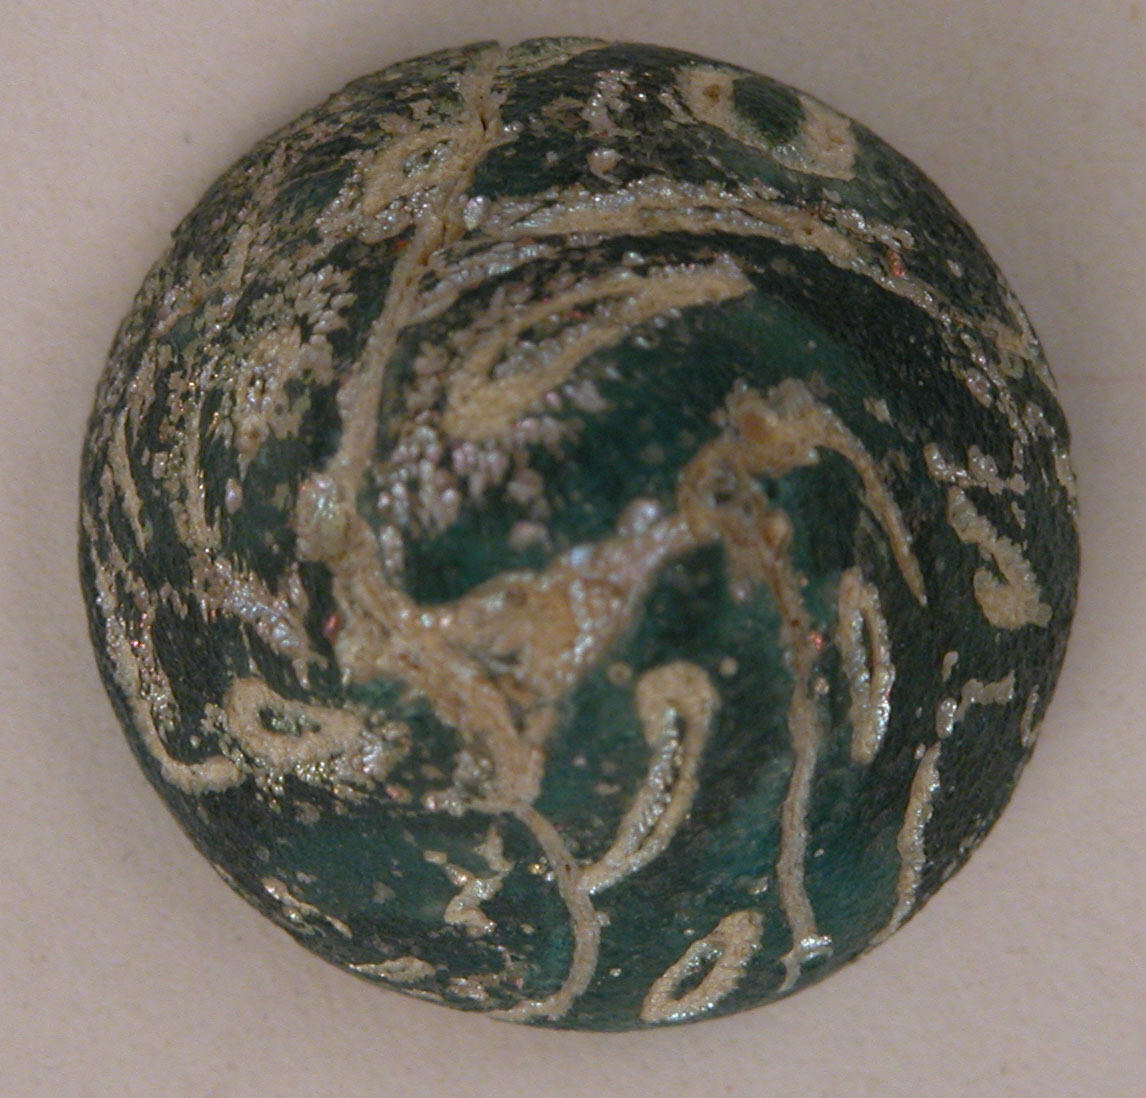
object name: gaming piece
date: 701-1200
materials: glass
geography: islamic lands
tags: games